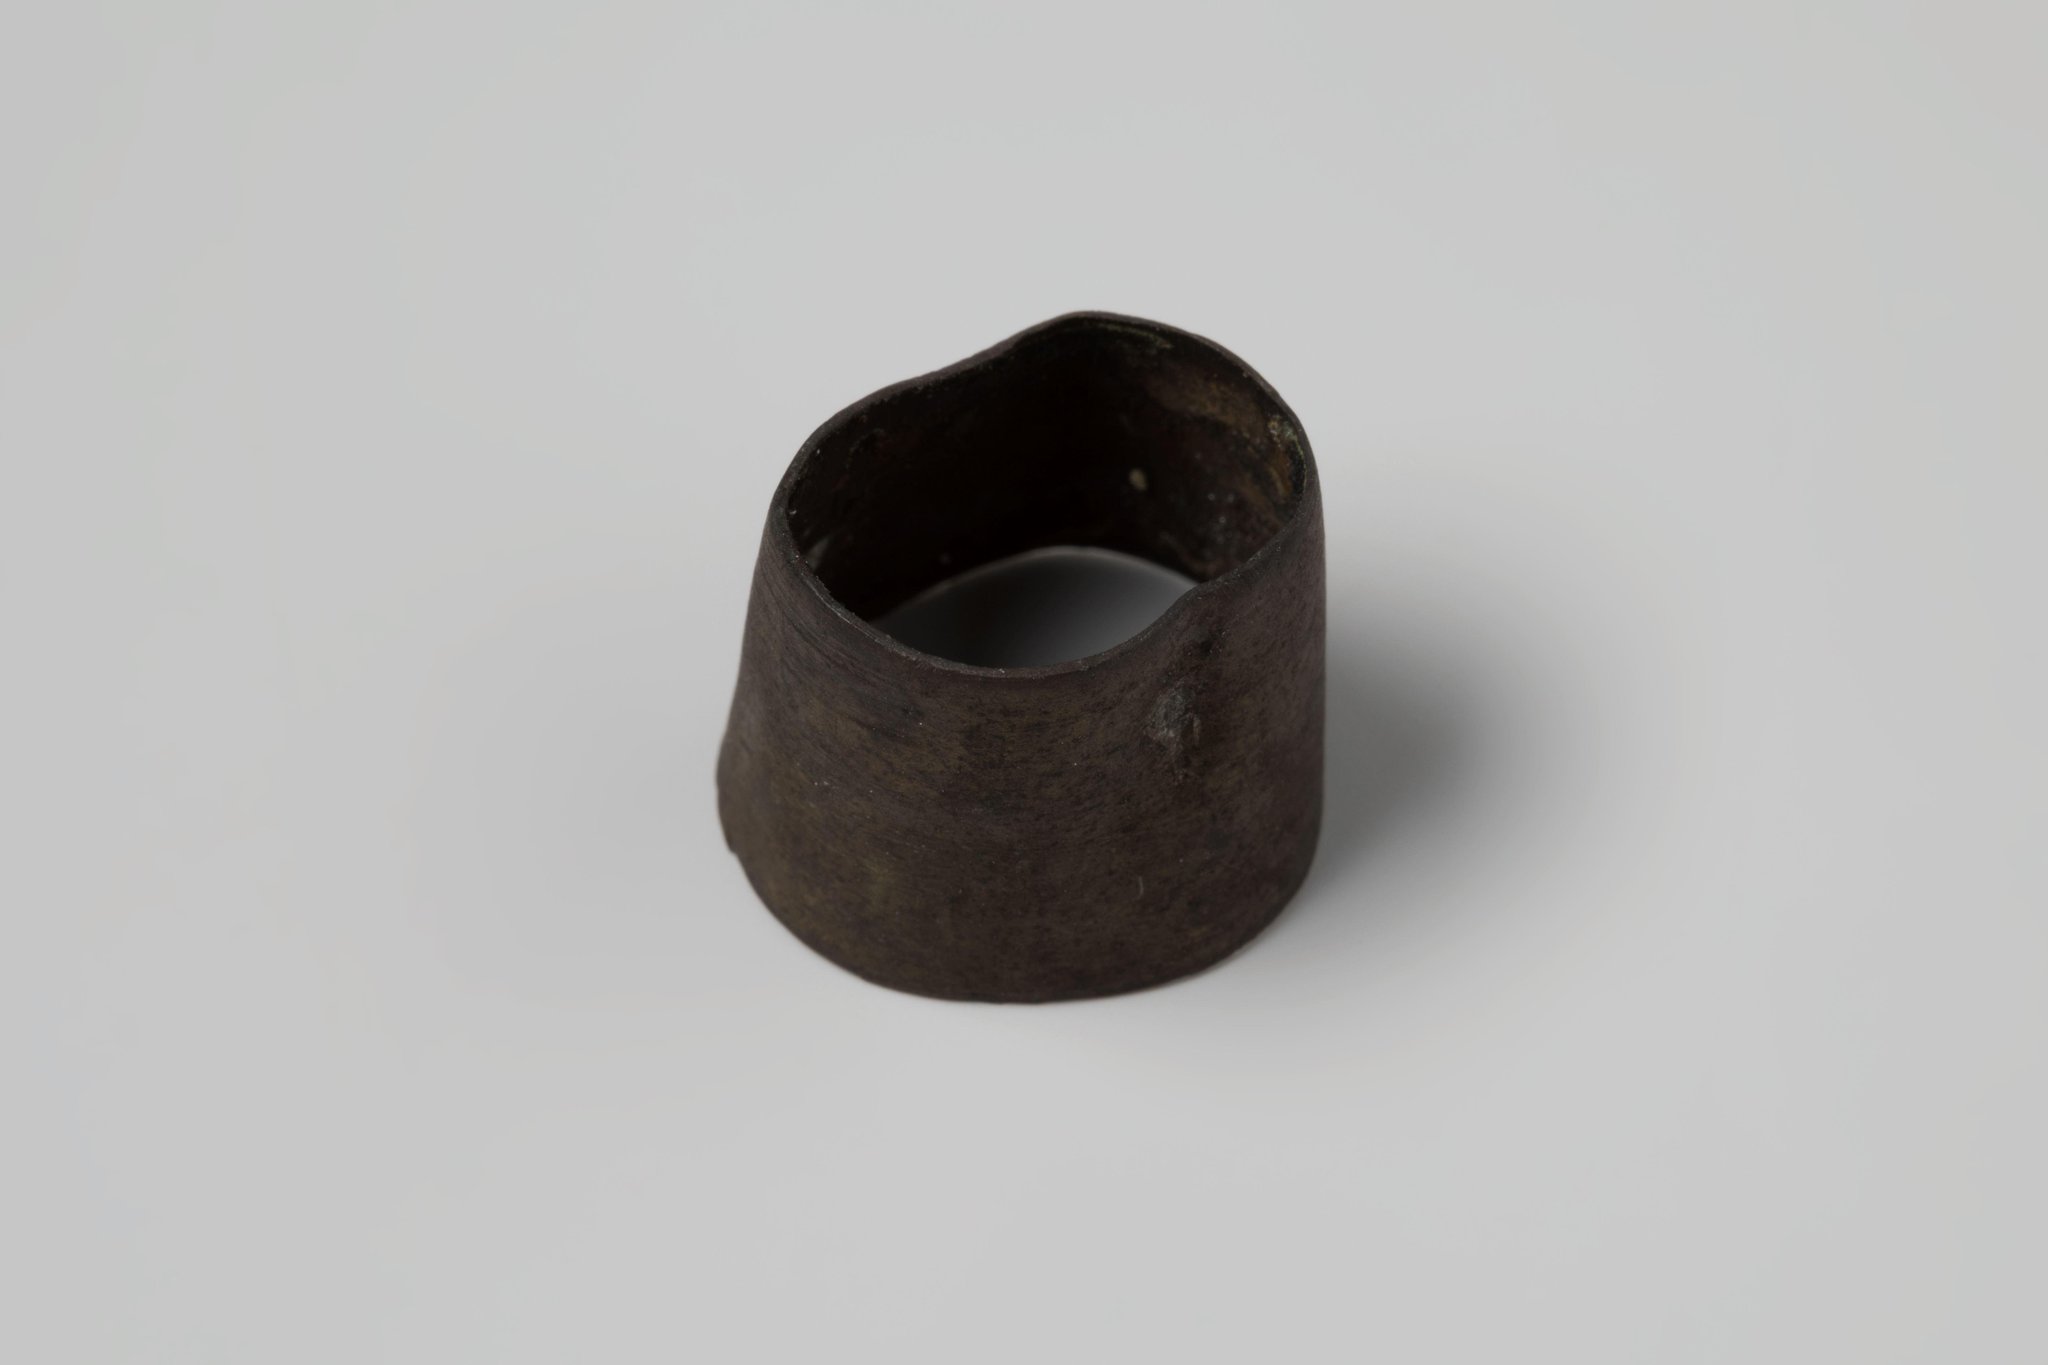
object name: knife handle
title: Messenheftring uit het wrak van de Oost-Indiëvaarder Hollandia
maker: Anonymous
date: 1700-1743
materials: copper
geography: netherlands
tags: verenigde oostindische compagnie, hollandia (schip), annet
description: Knife-handle, ferrule; broad ring, circular.